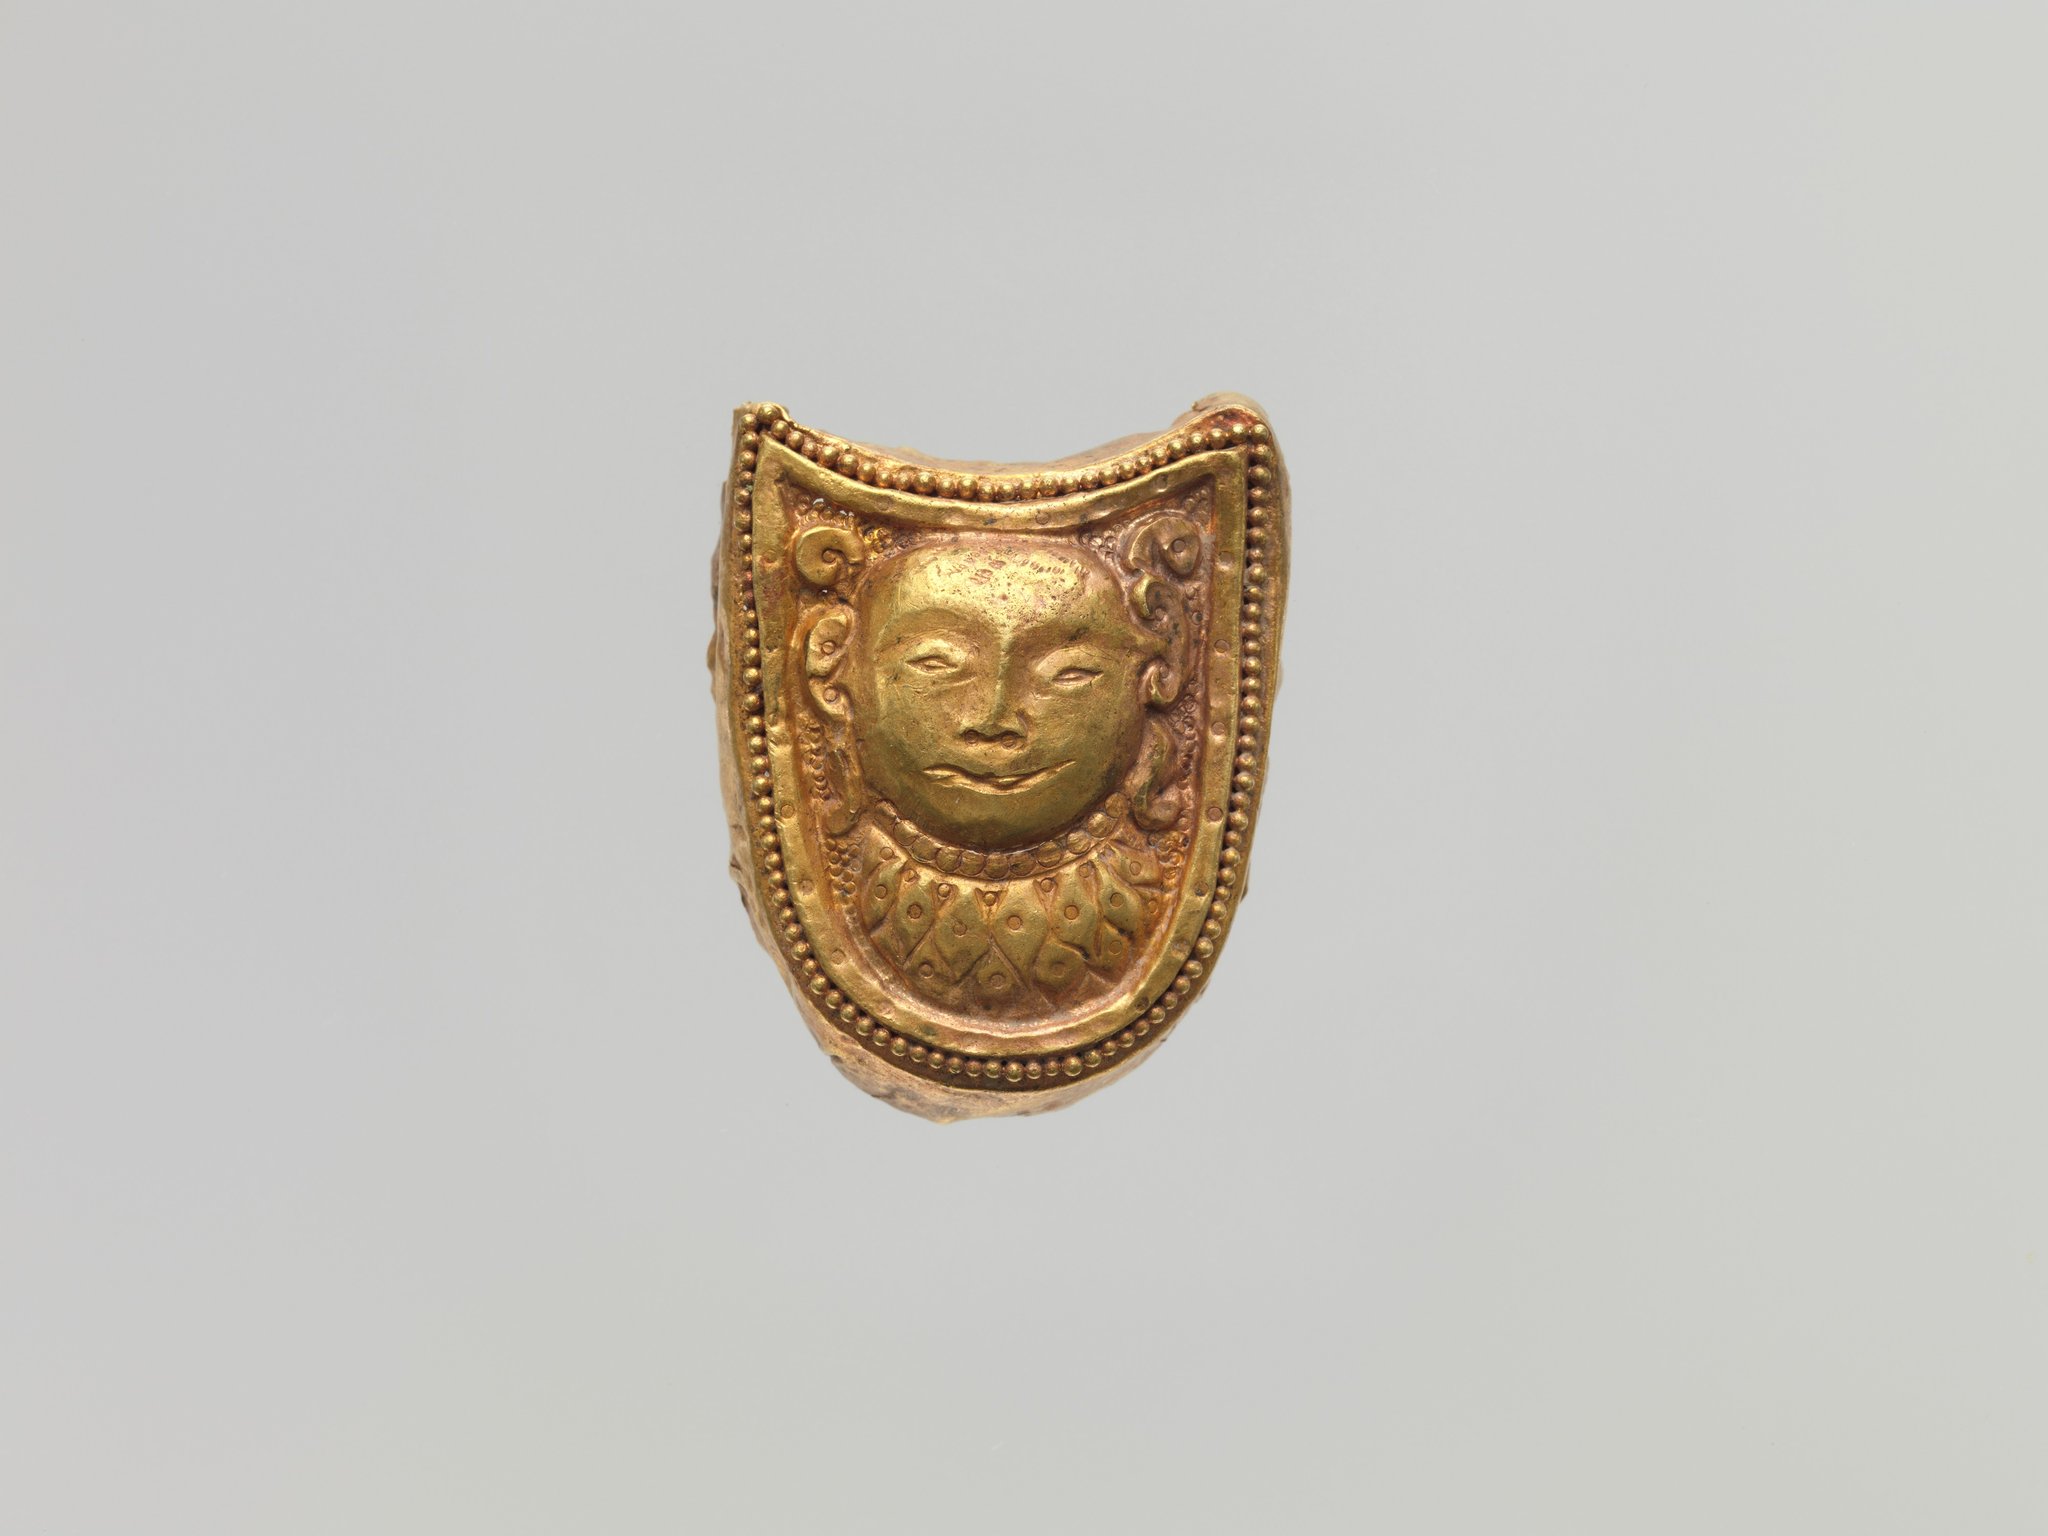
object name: plaque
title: Plaque with Head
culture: chinese or central asian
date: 601-900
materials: gold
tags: heads